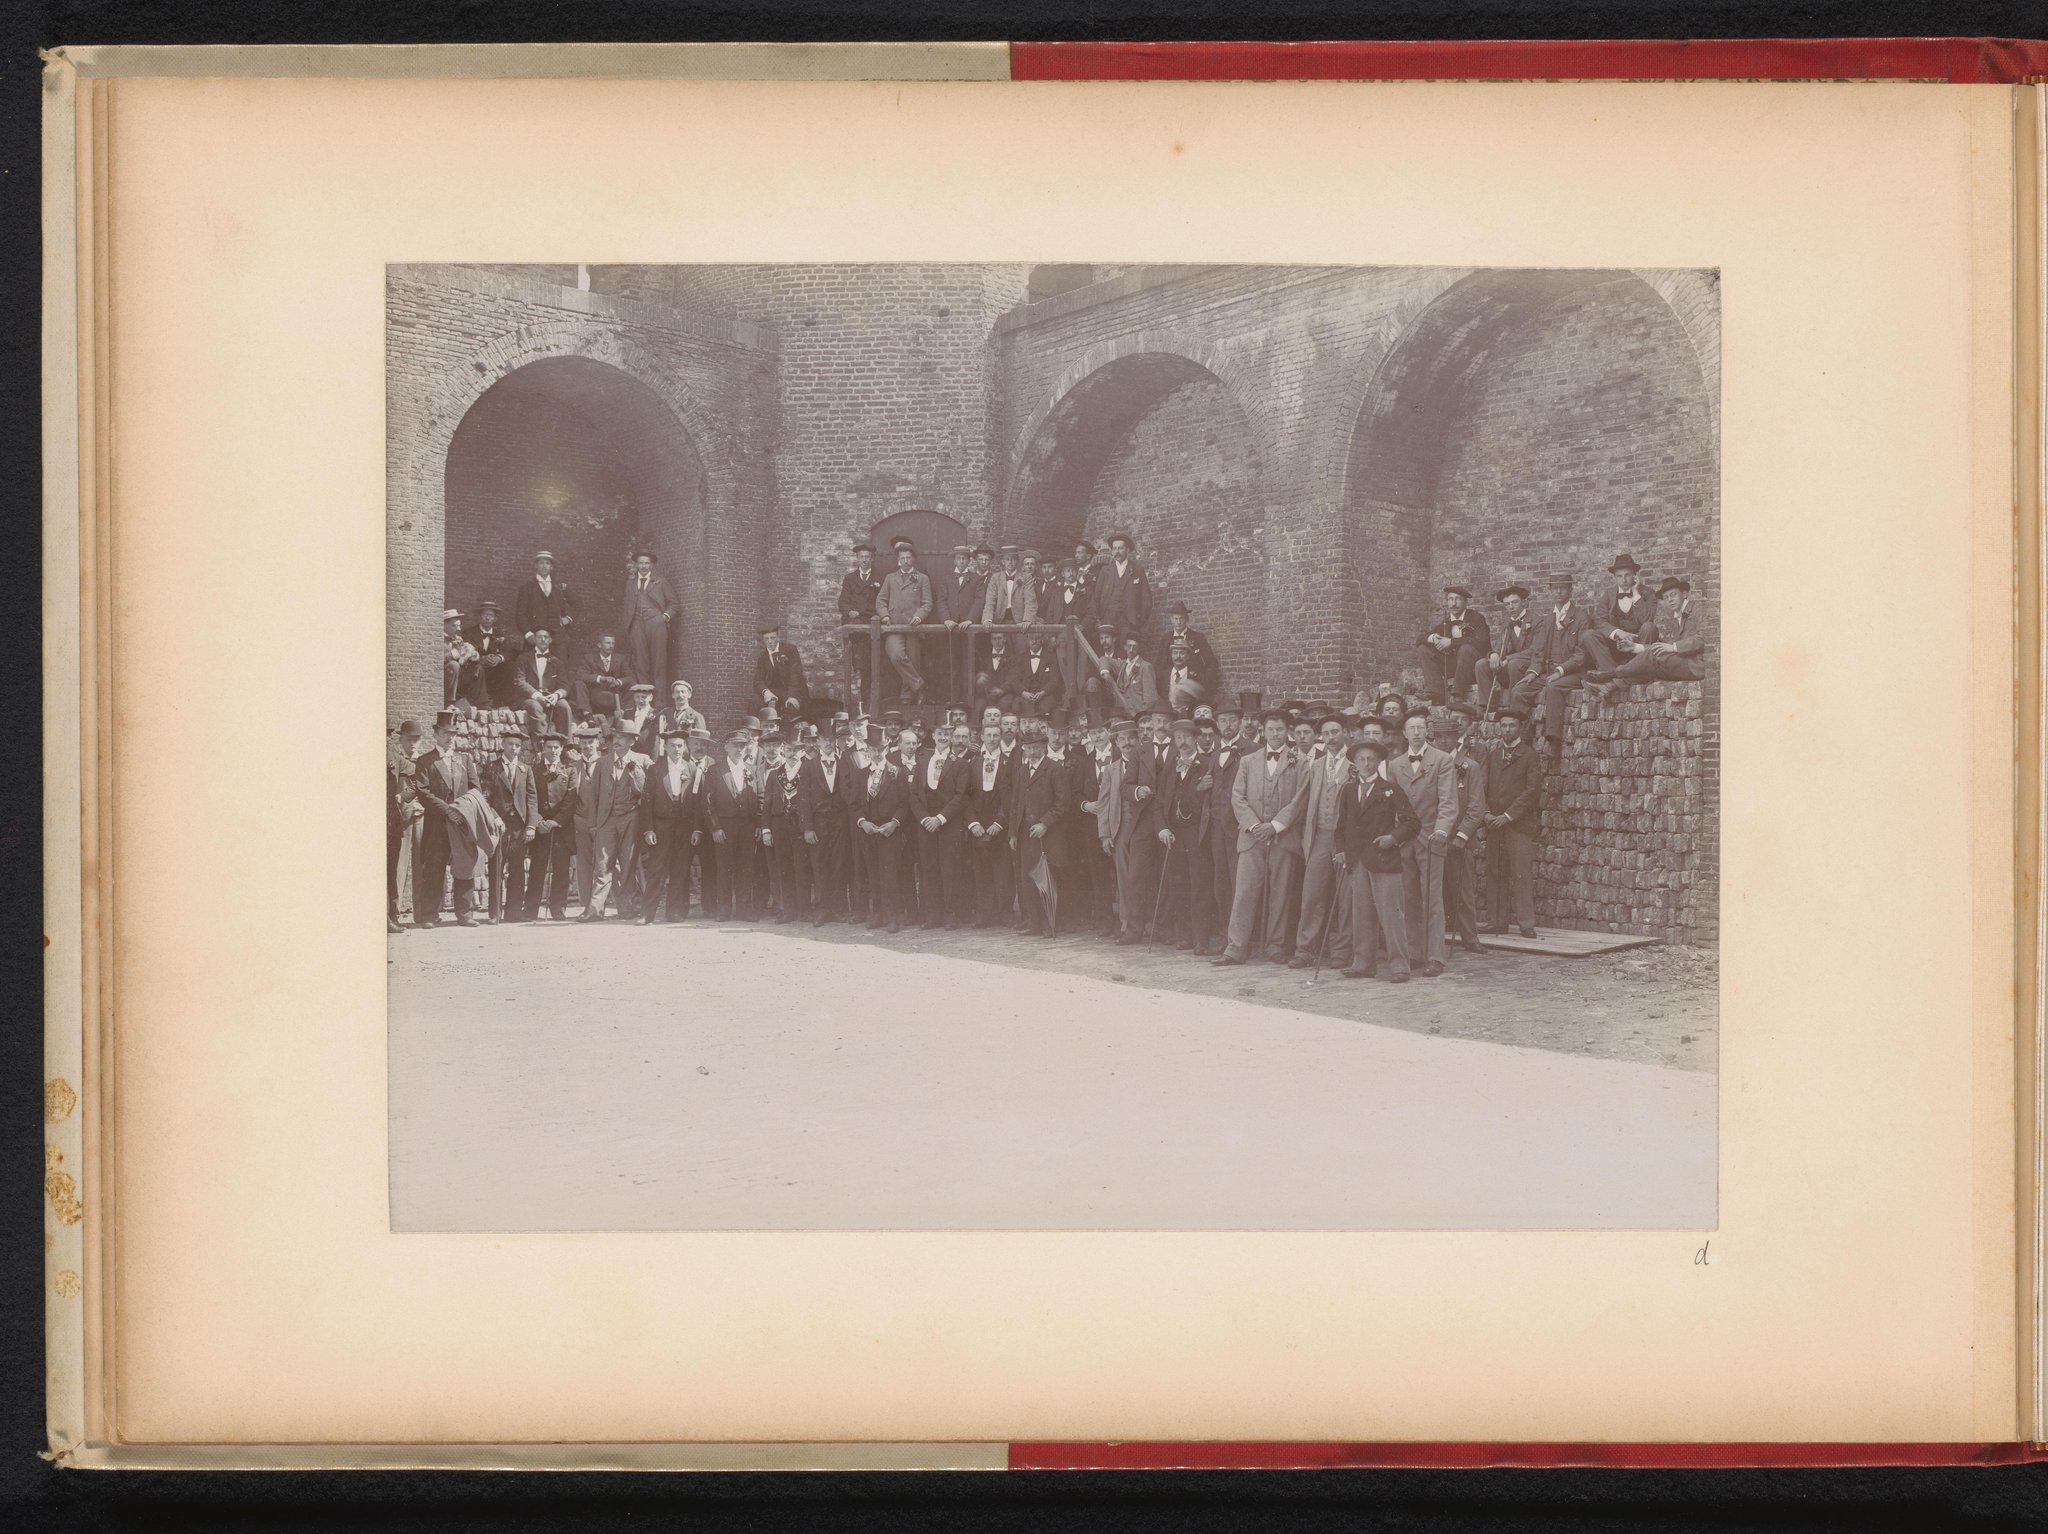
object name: photograph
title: Groepsportret van het Amsterdamsch Studenten Corps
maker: nicolaas schuitvlot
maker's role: fotograaf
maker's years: 1859-1947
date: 1806-1897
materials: cardboard, photographic support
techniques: collodion silver print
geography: netherlands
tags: students' organization, anonymous historical persons portrayed in a group, in a group-portrait, netherlands